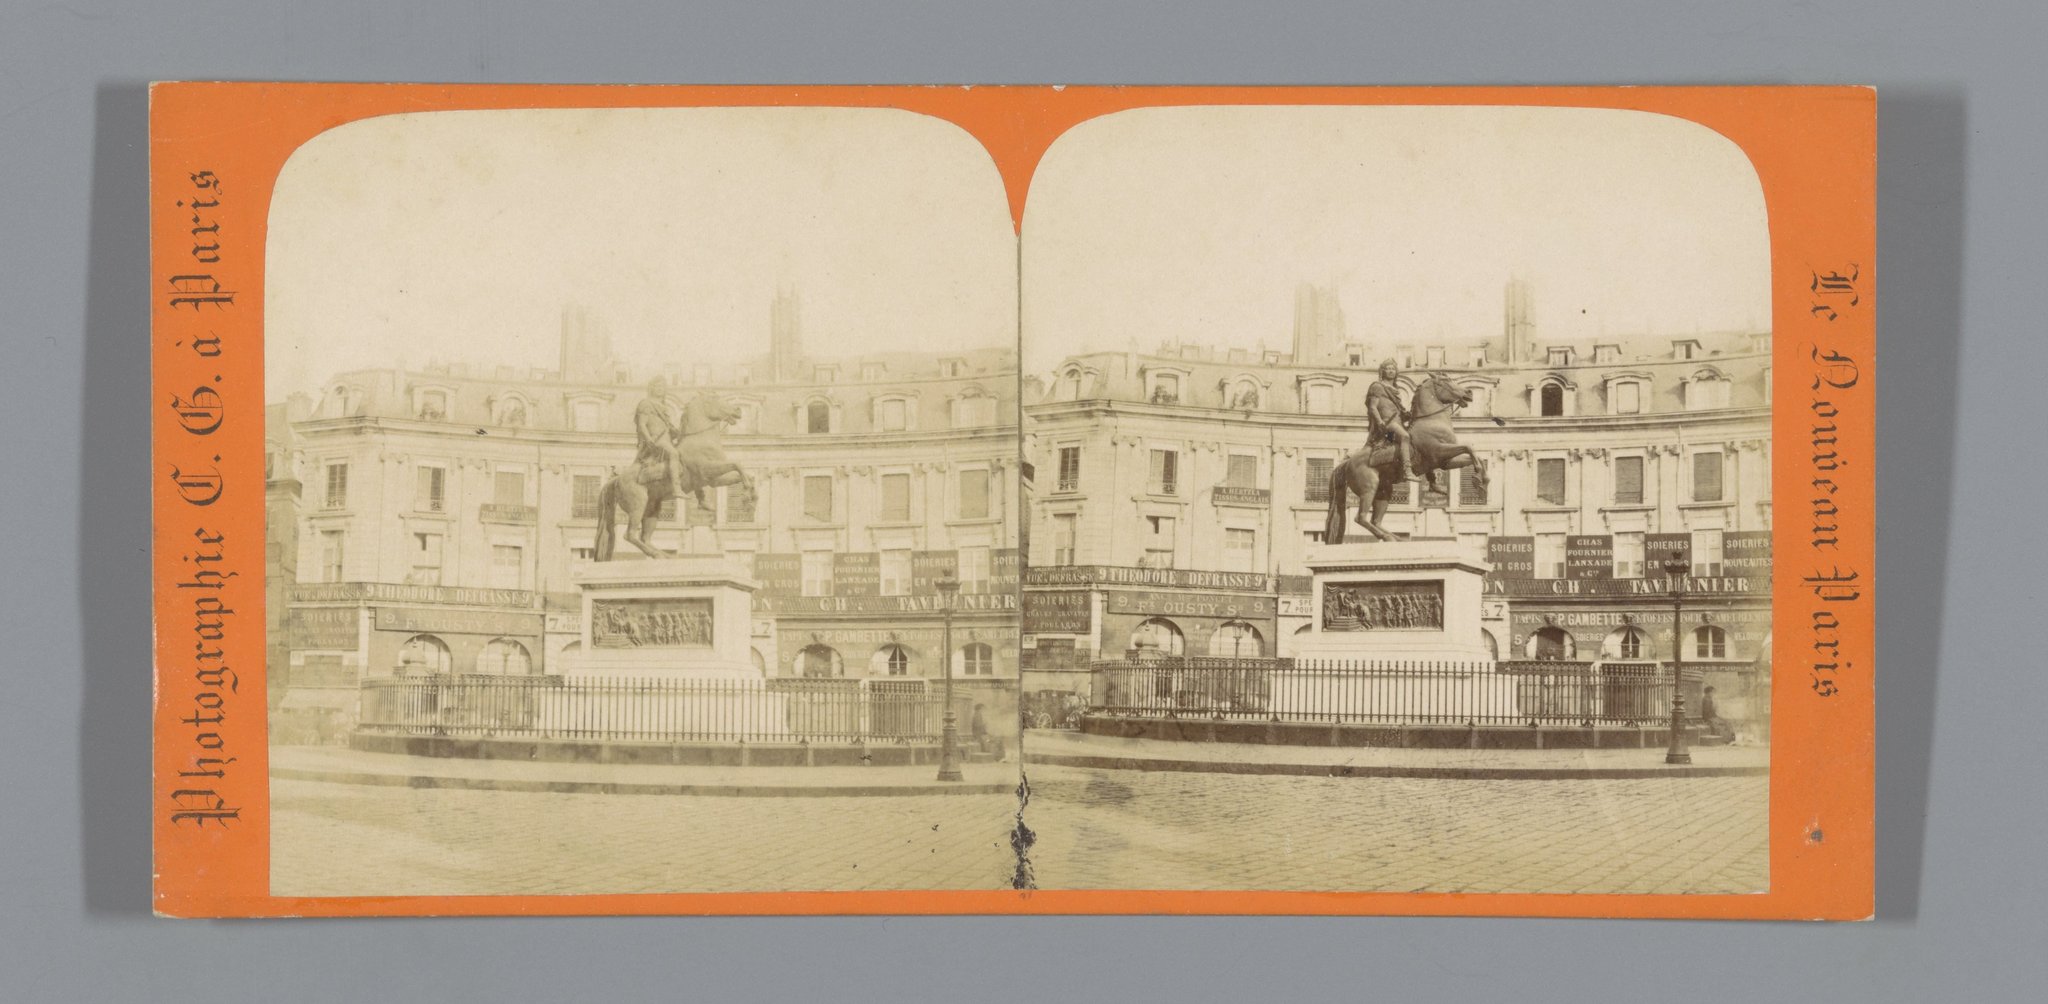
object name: stereograph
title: Le Nouveau Paris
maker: charles gérard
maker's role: fotograaf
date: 1860-1870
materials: cardboard, photographic support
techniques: albumen print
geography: paris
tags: square, place, circus, etc., equestrian statue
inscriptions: inscription: ‘Place des Victoires’, inscription: ‘Photographie C. G. à Paris.’